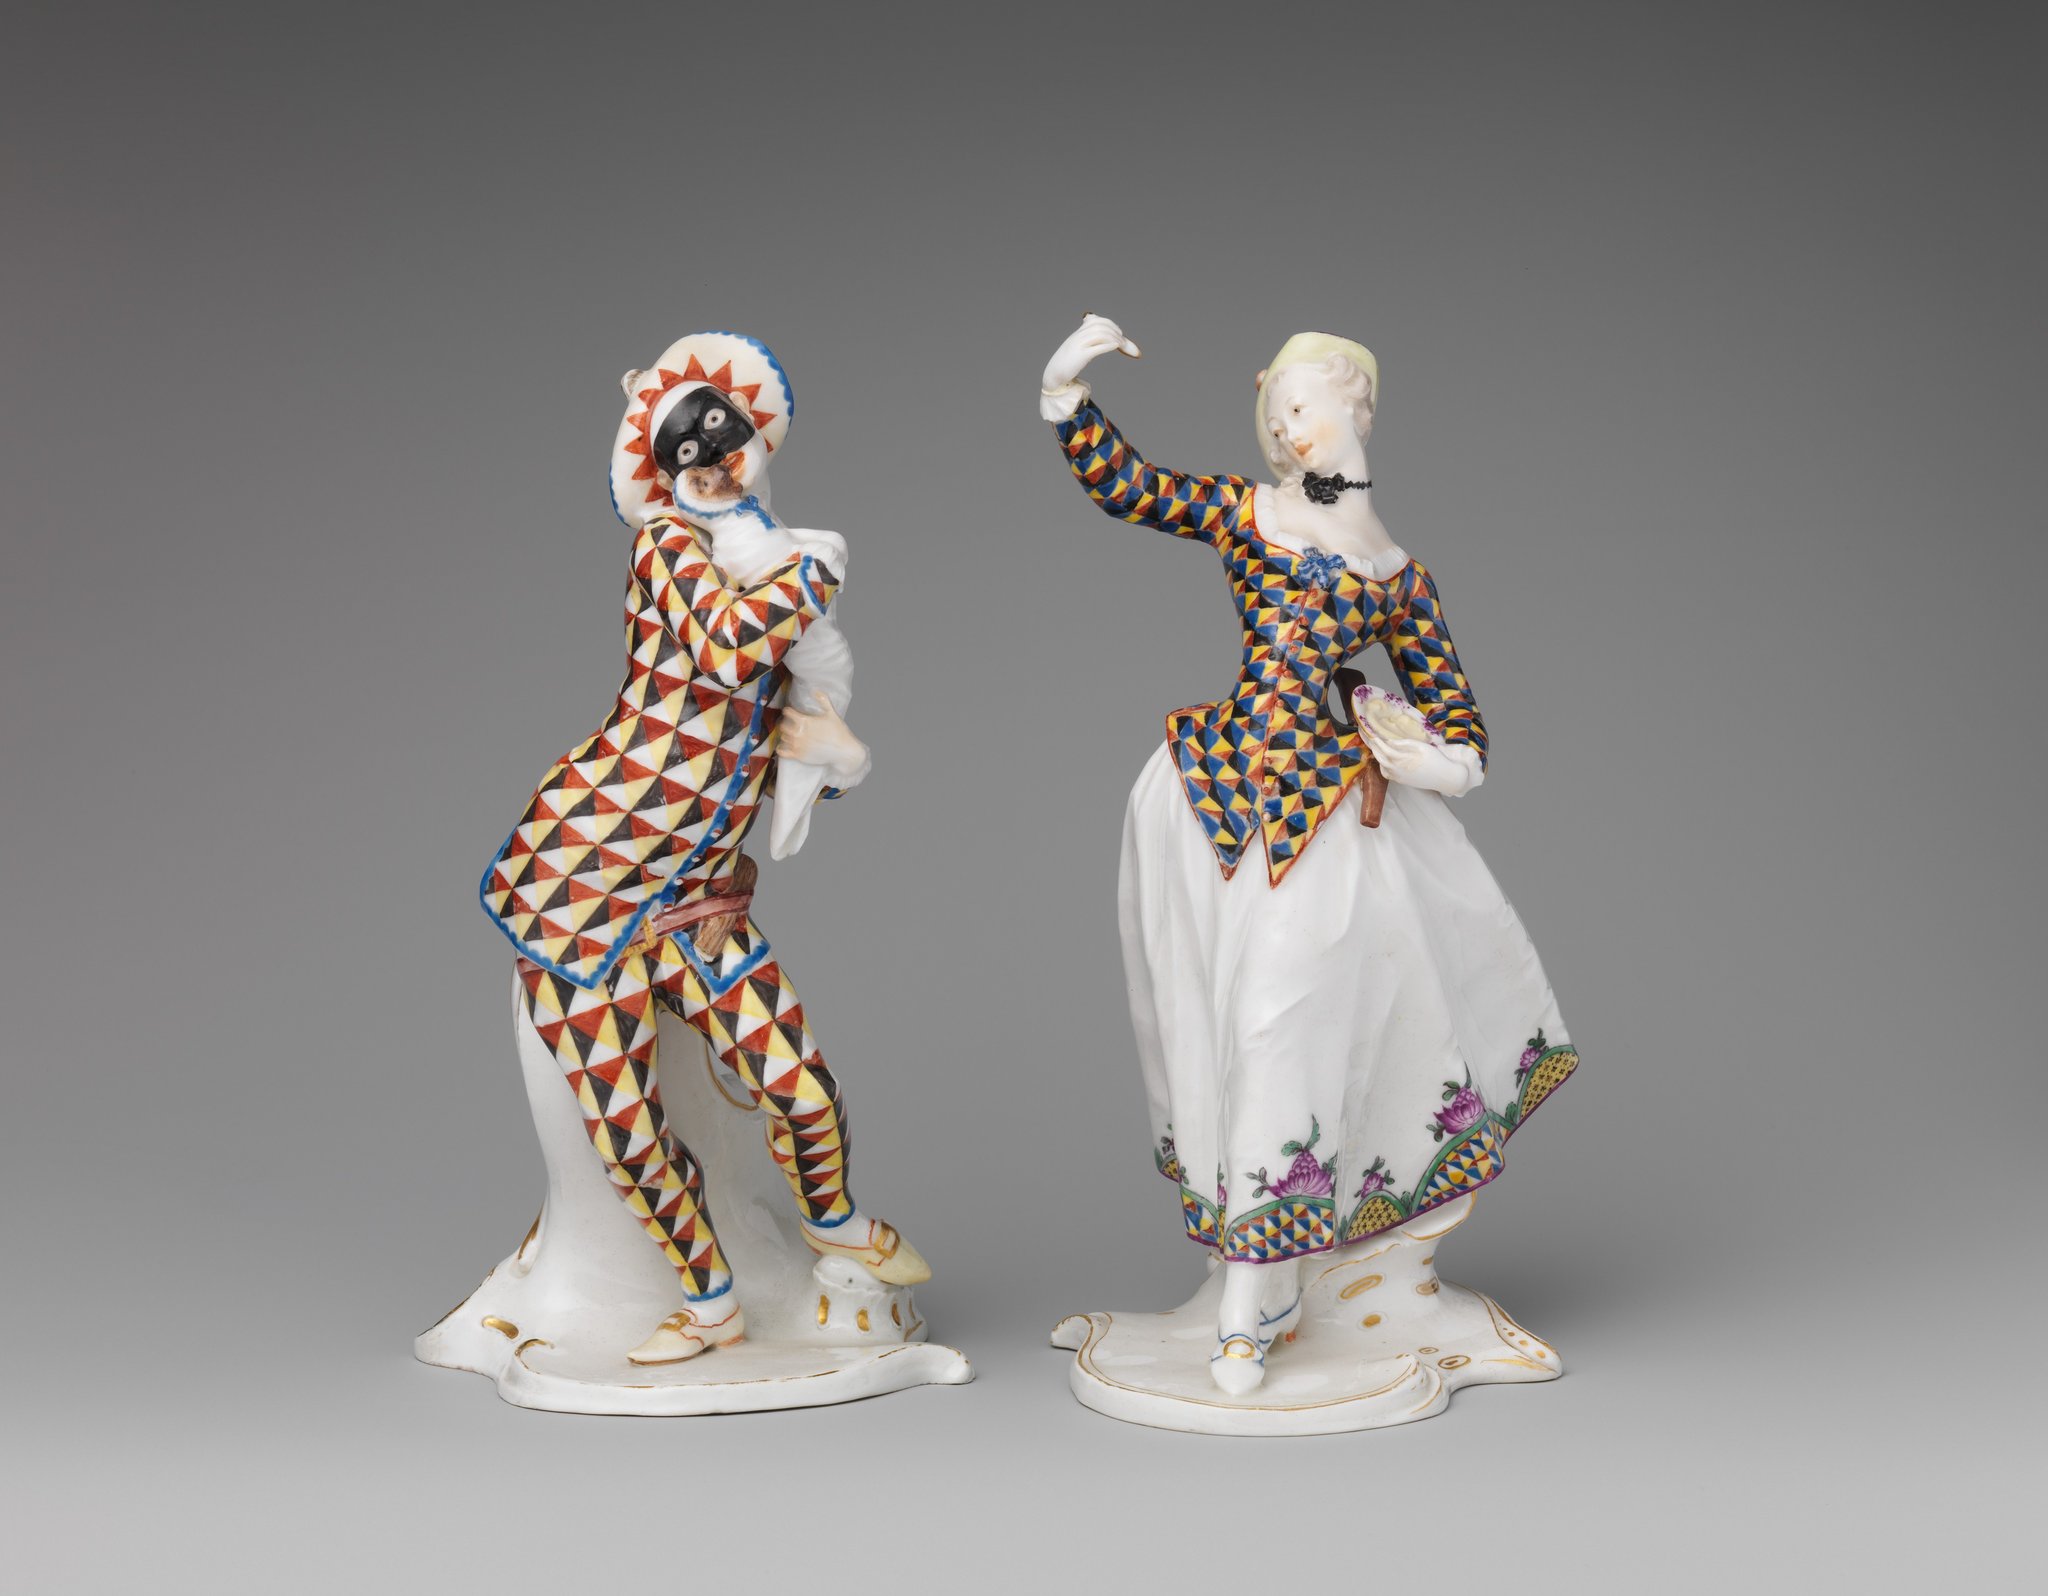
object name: figure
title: Harlequin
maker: nymphenburg porcelain manufactory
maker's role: manufactory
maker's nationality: german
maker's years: 1747-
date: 1760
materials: hard paste porcelain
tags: men,women,dancing